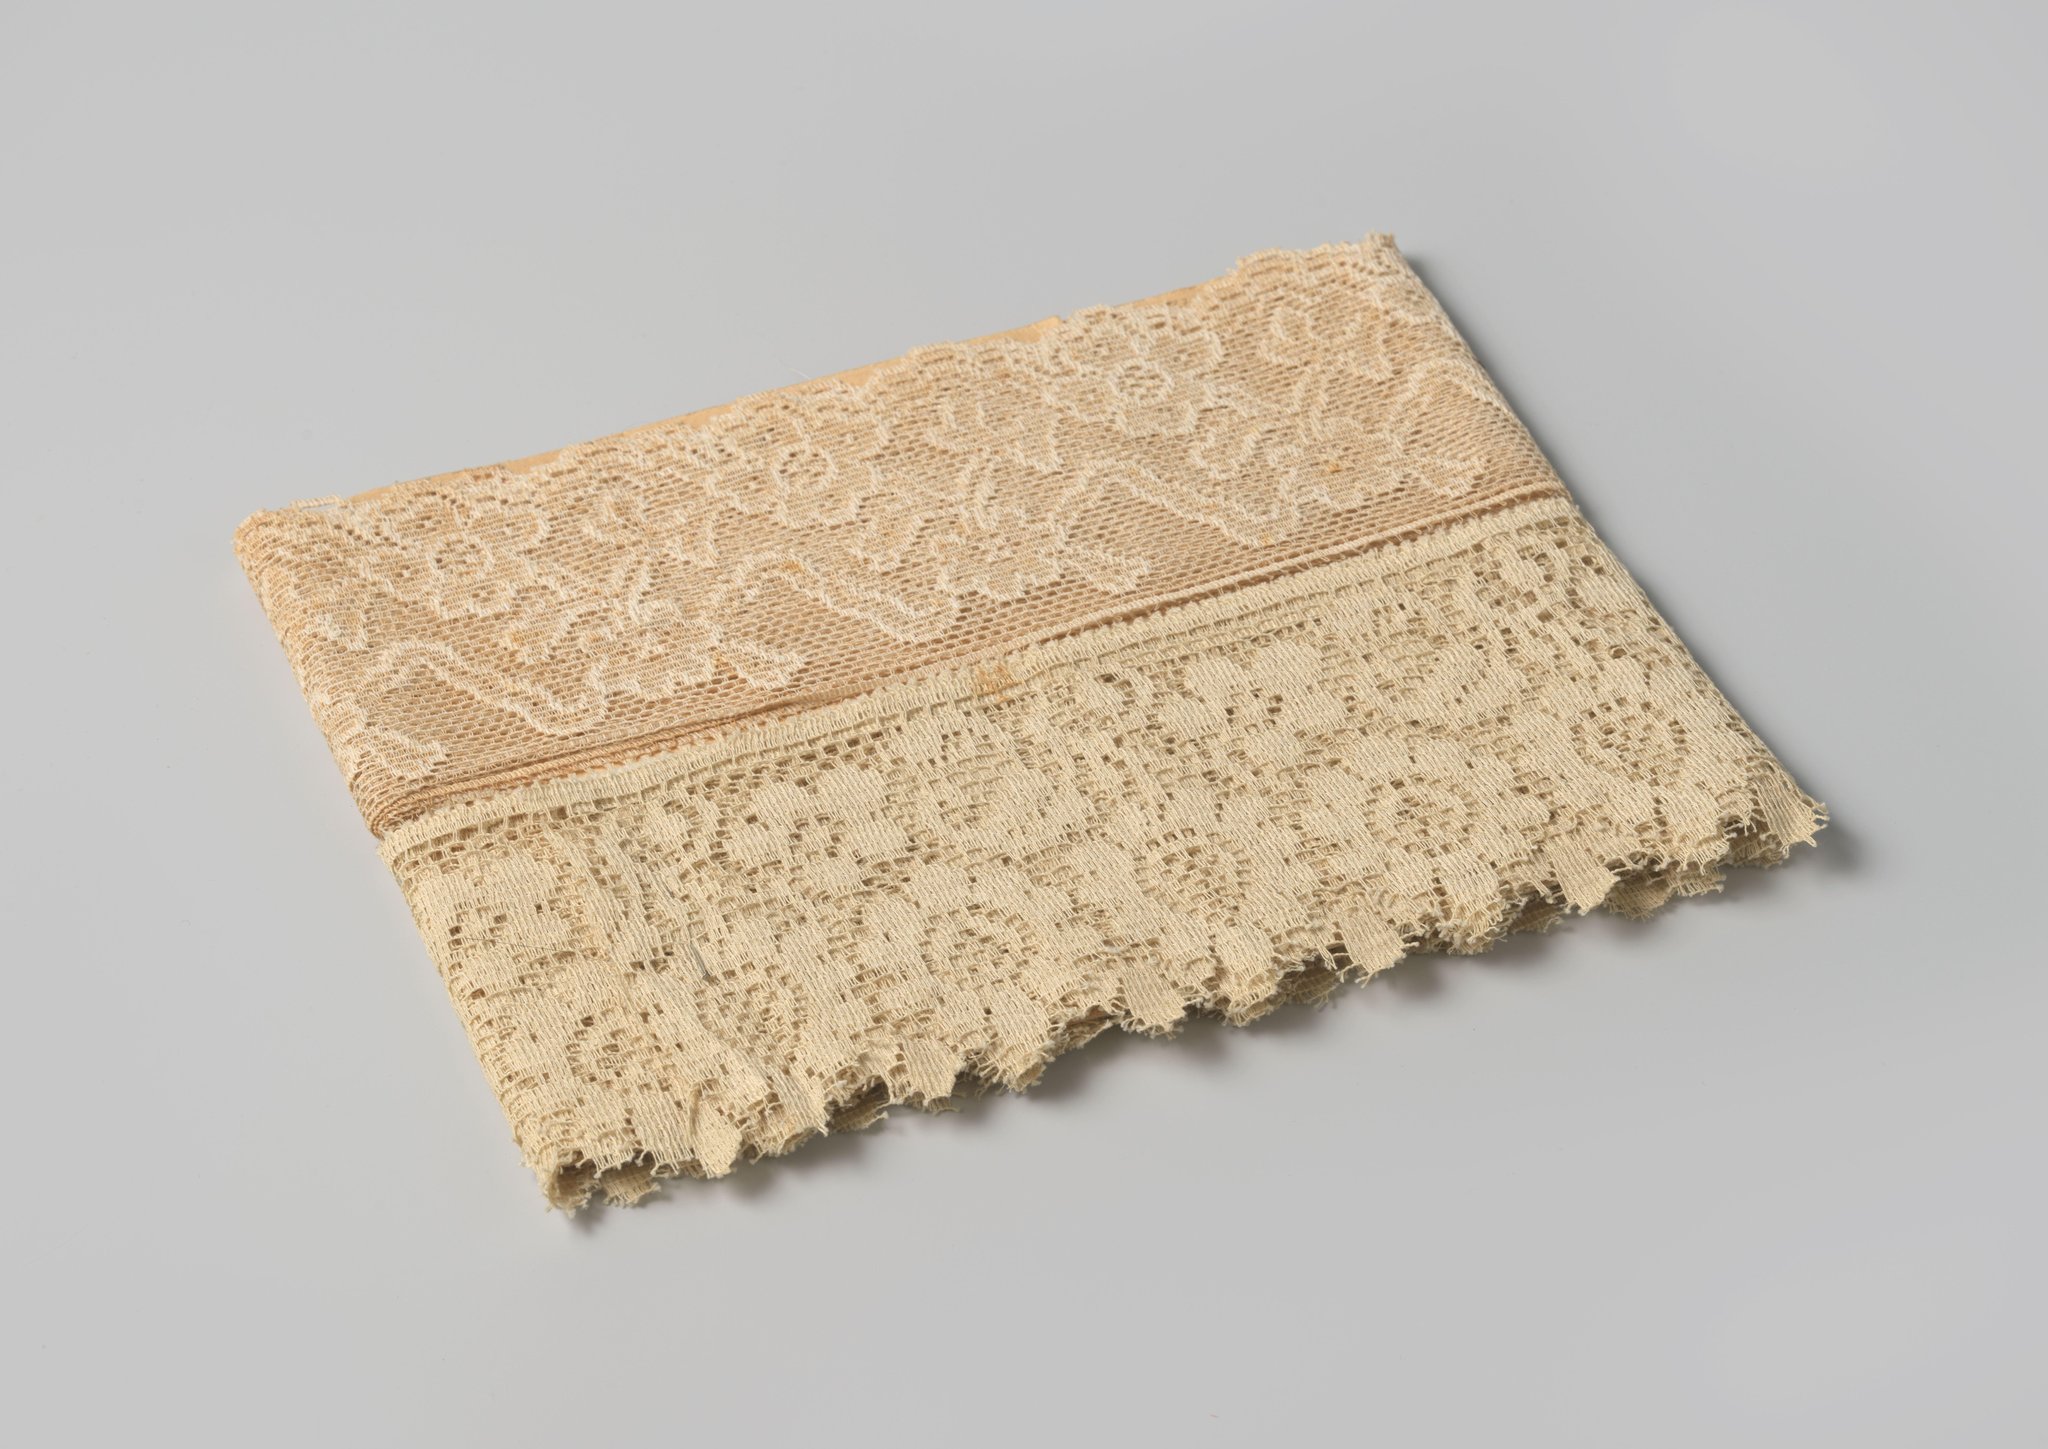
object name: braid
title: Strook kant, wit, aan één zijde geschulpt gedecoreerd met bloemmotief, op karton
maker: gustav schnitzler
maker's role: paraplufabrikant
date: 1925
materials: cardboard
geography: nijmegen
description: Metrages kant en passement, in wit en zwart en andere kleuren. Karton met witte geschulpte kant.